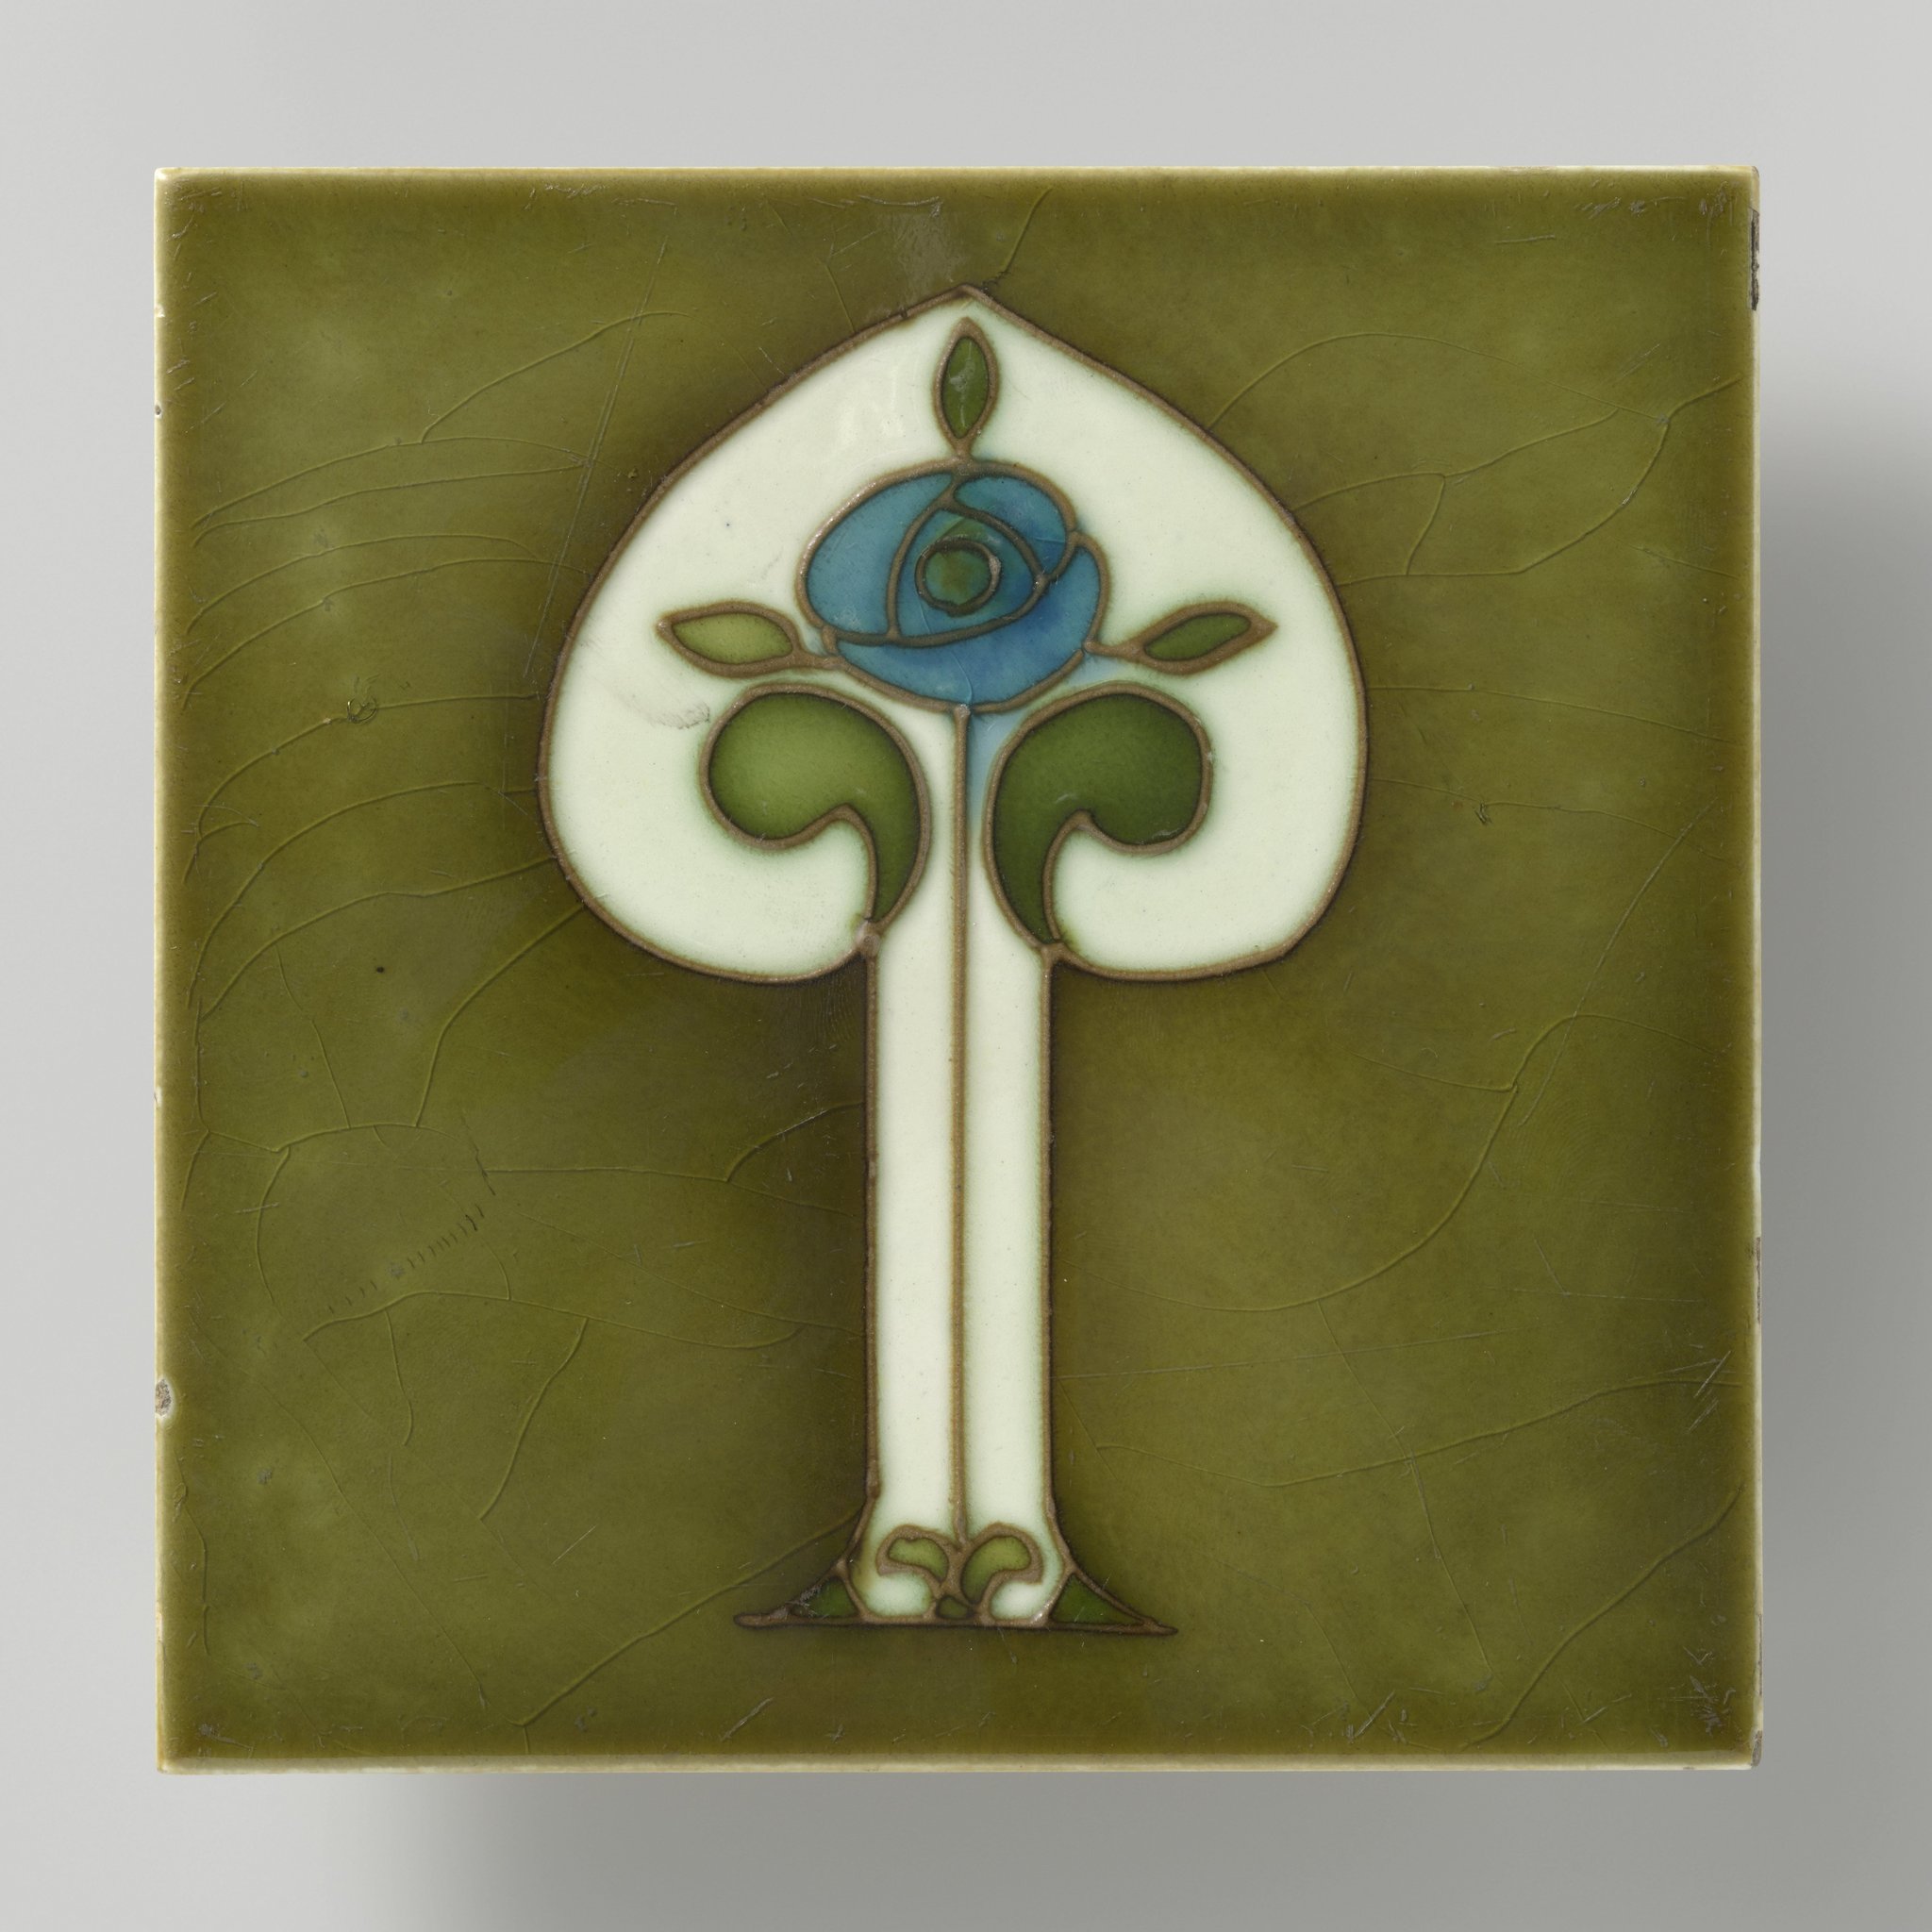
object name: tile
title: Tegel van steengoed, versierd met gestileerde boom met roosachtige bloem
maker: Anonymous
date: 1900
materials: stoneware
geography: england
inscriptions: mark: ‘ENGLAND en T92’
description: Tegel van steengoed, versierd in groen en blauw met gestileerde boom met roosachtige bloem.